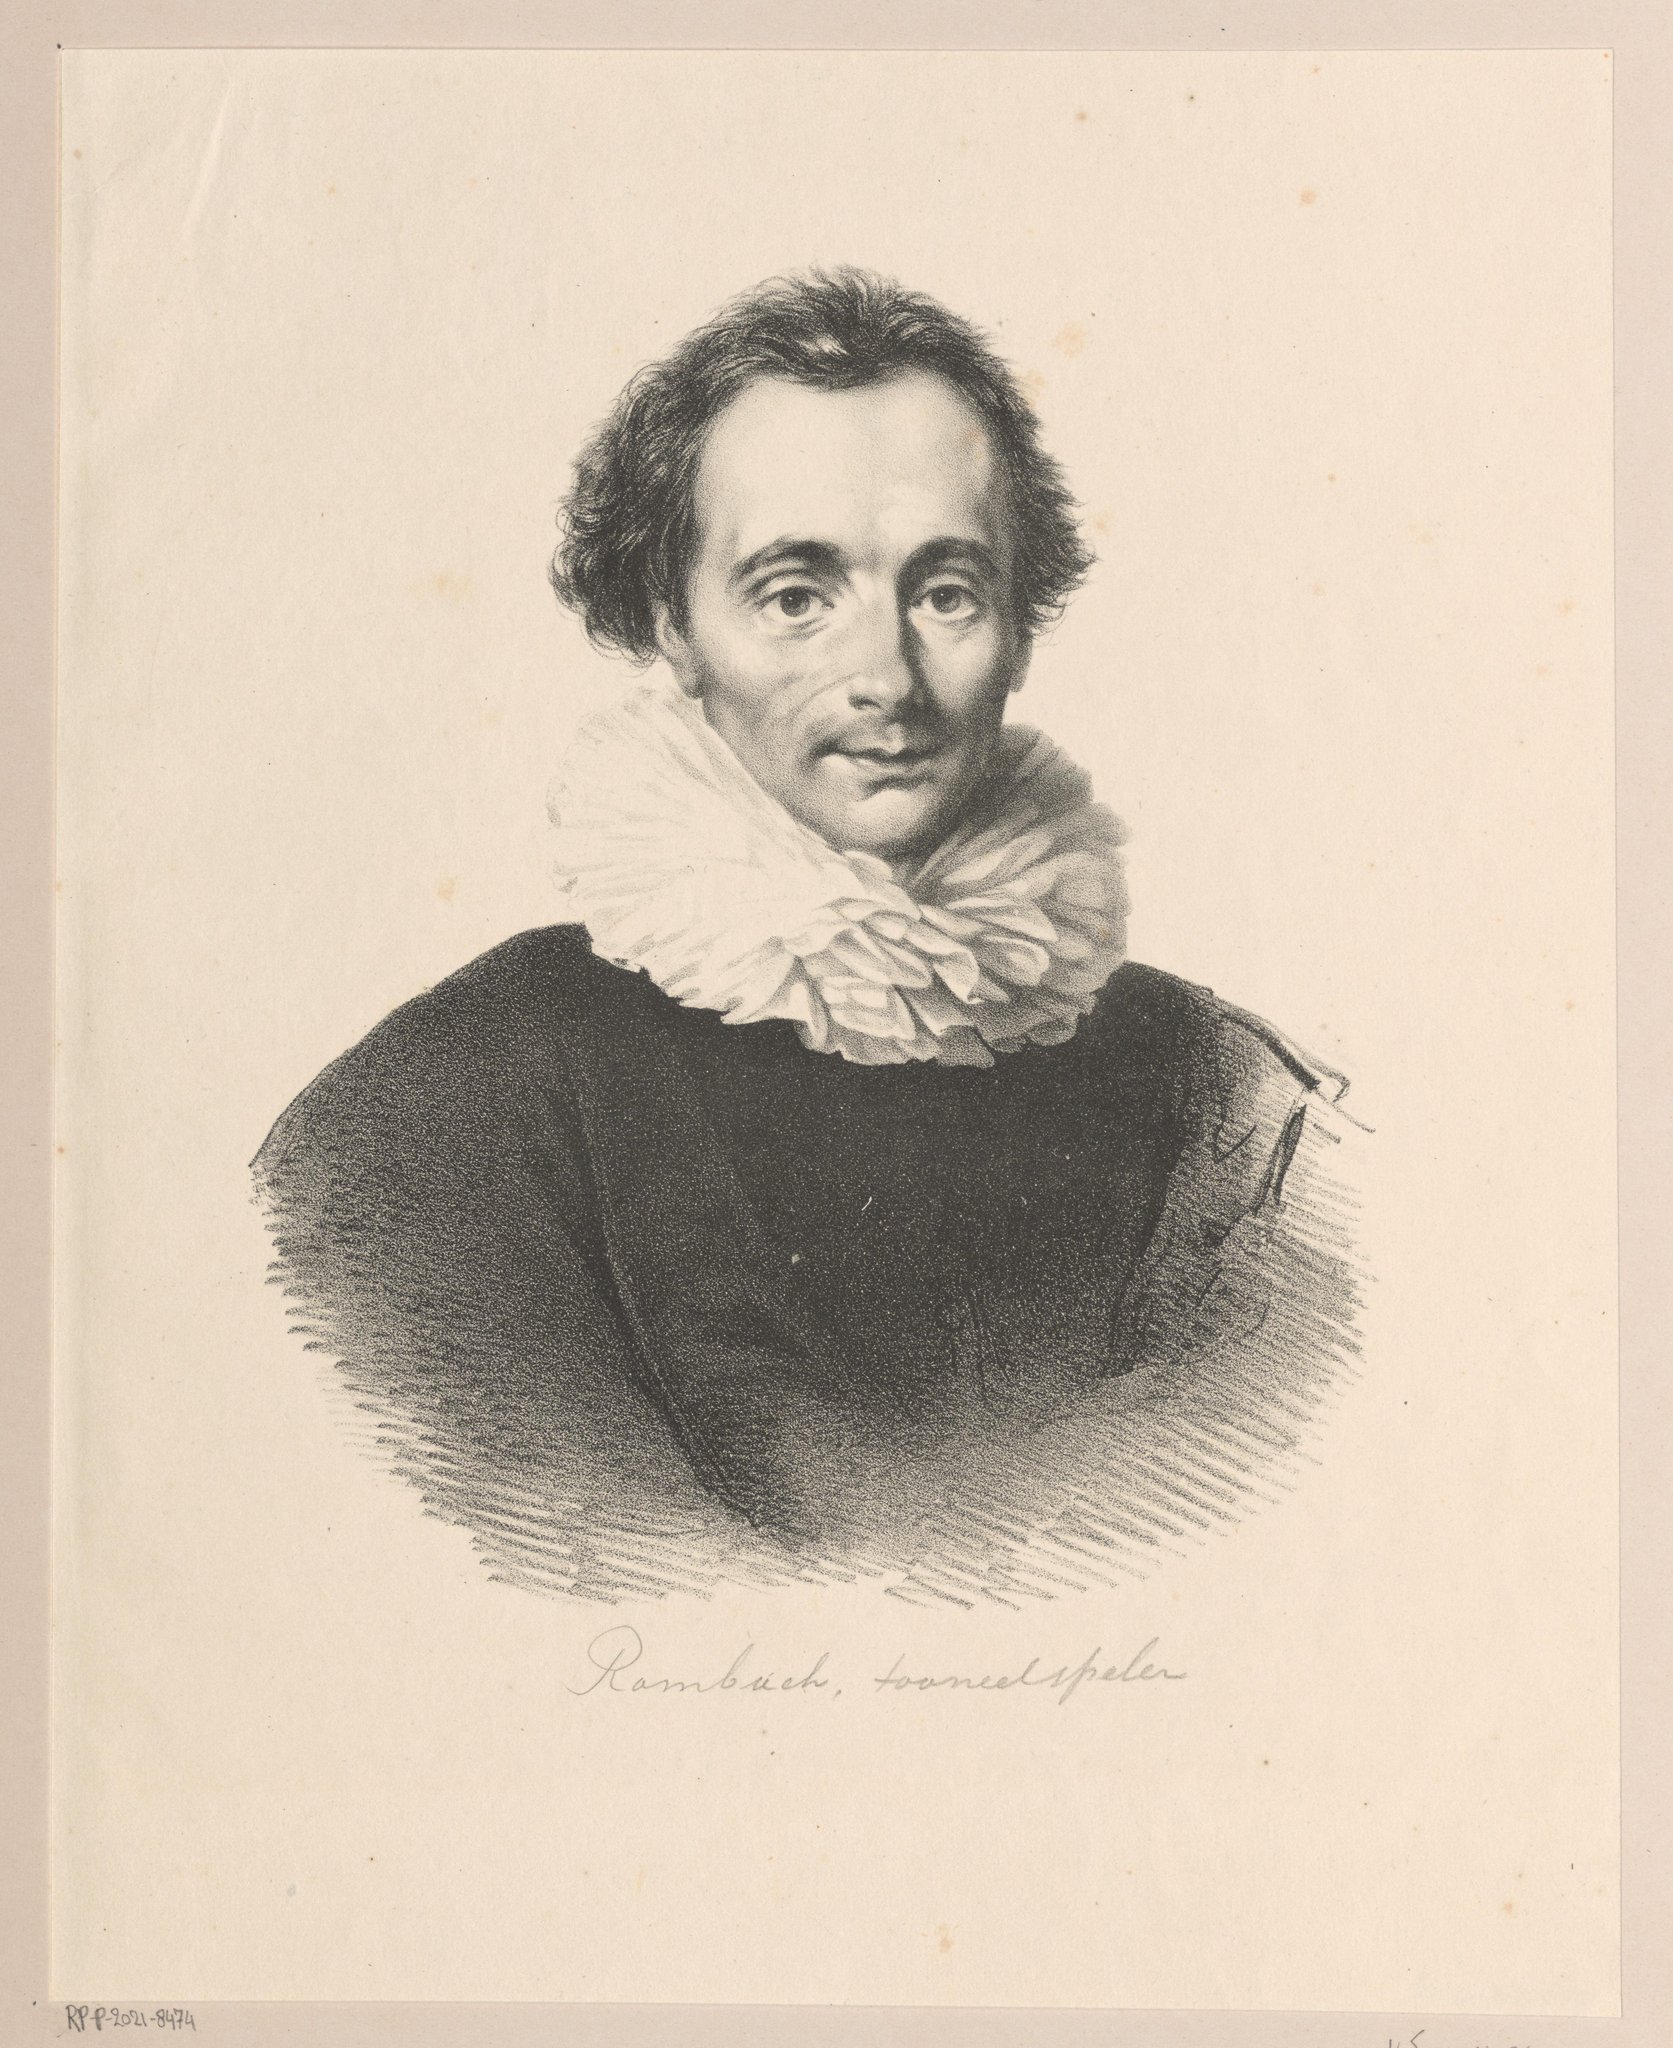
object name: print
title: Portret van Gerrit Carel Rombach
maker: jean augustin daiwaille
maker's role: draughtsman, print maker, printer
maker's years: 1786-1850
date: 1810-1850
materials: paper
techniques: lithograph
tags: historical persons